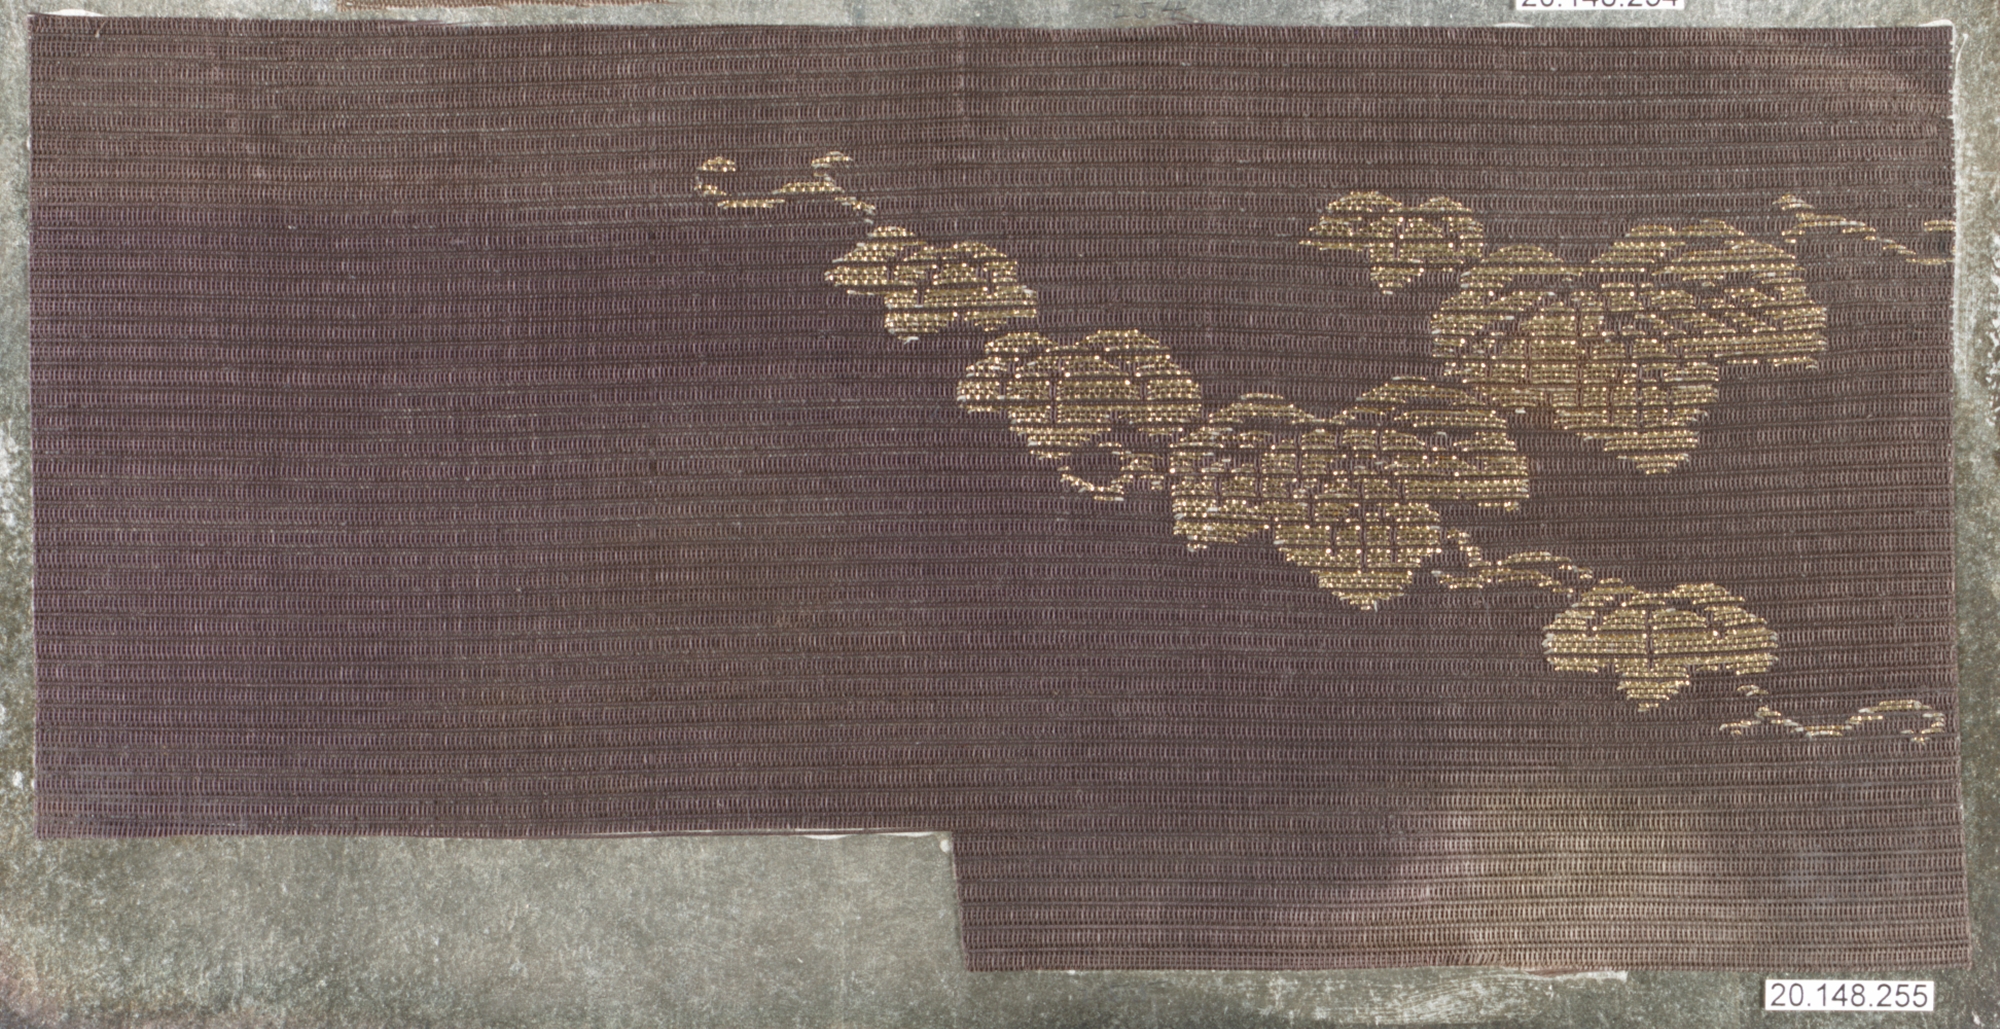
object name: piece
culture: japanese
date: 1701-1800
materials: silk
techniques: compound weave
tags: leaves